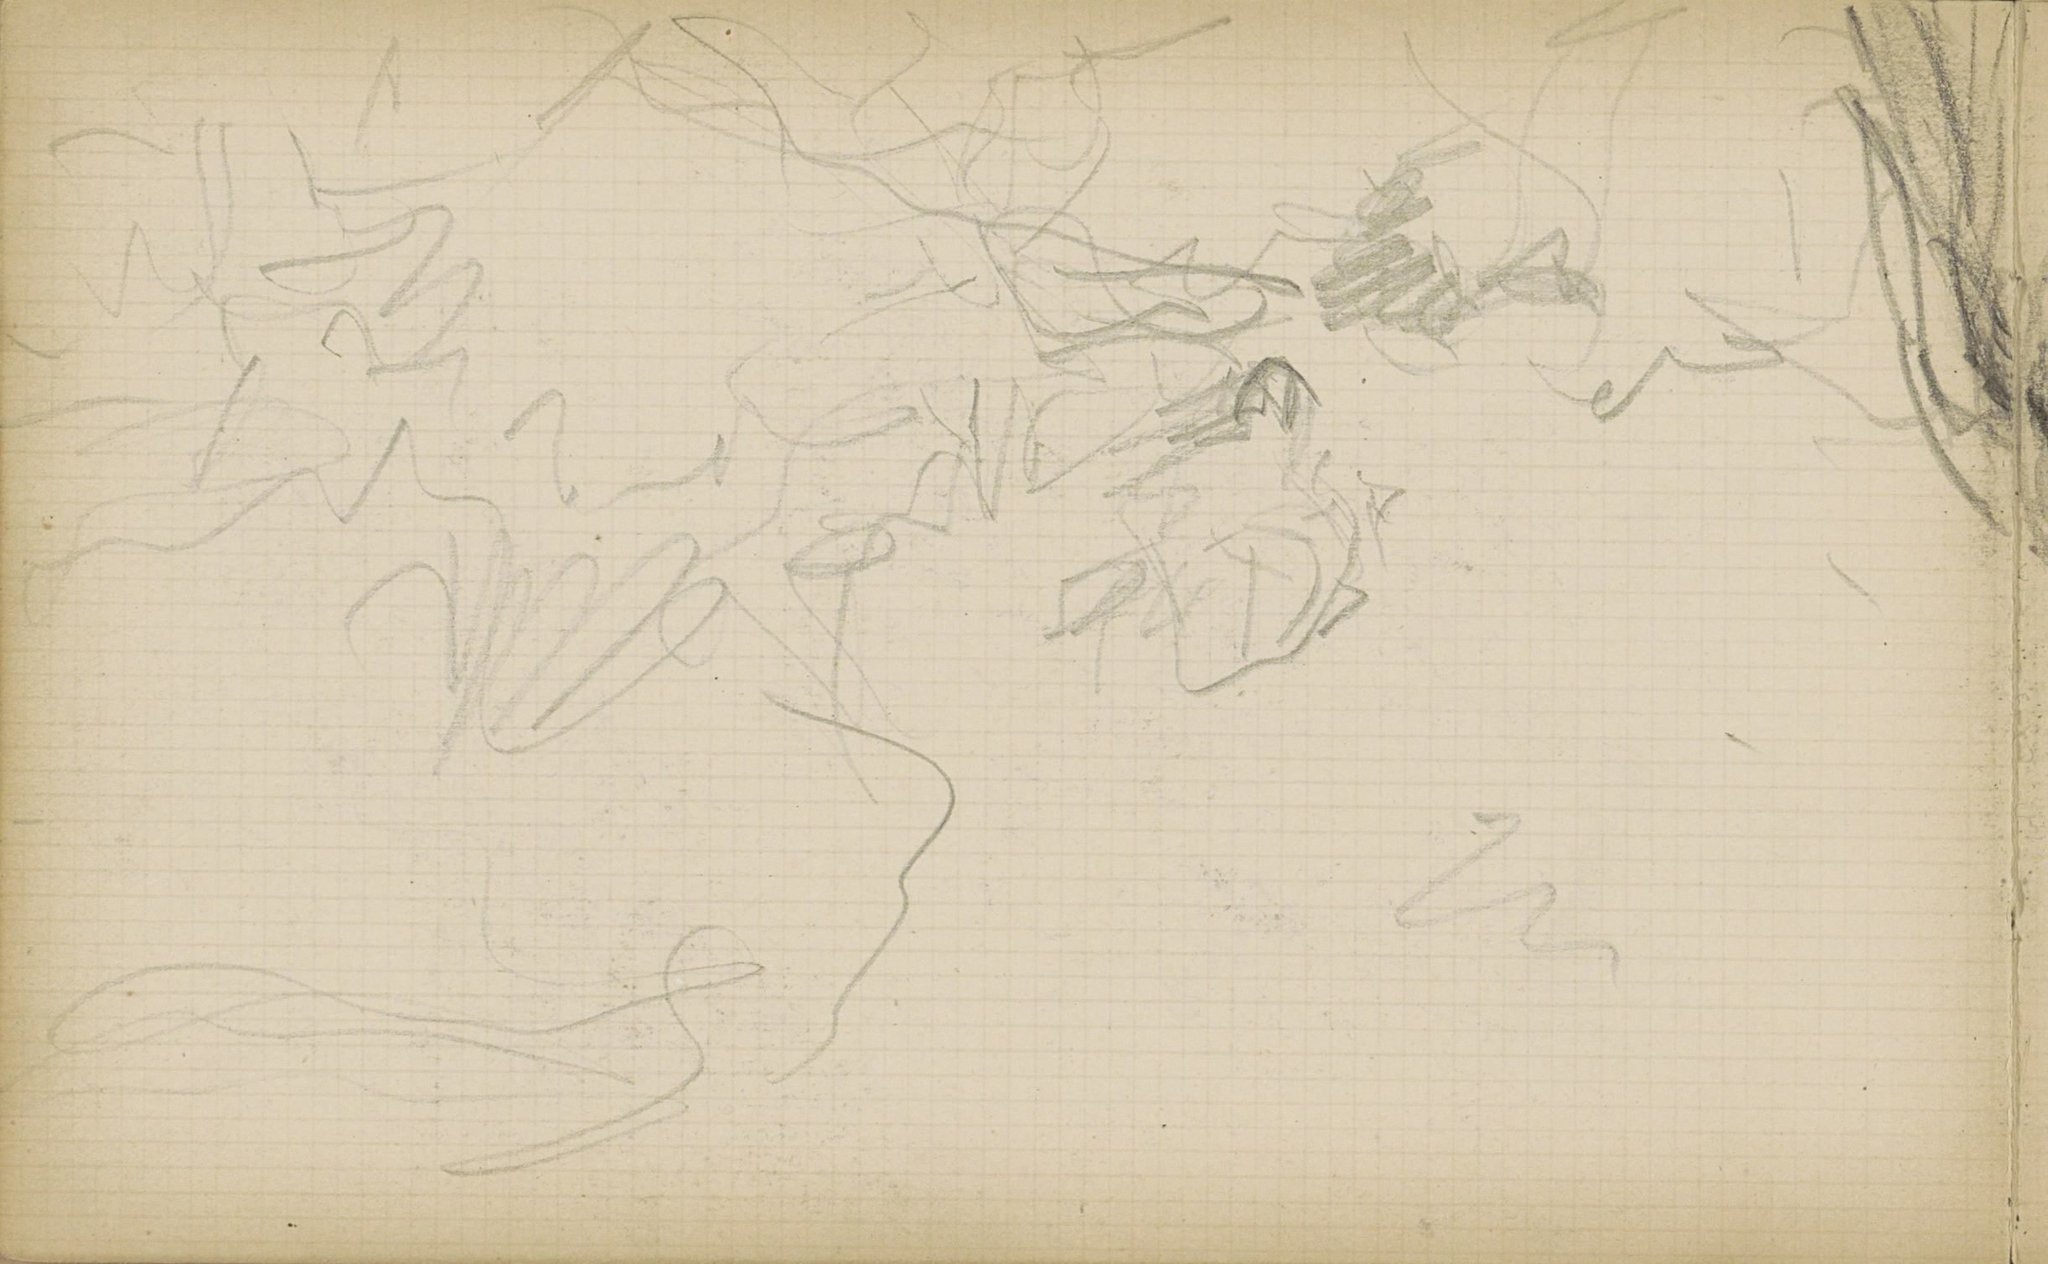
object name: sketchbook leaf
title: Studie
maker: matthijs maris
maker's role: draughtsman, painter, print maker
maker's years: 1839-1917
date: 1849-1917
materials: pencil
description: Blad 17 verso uit een schetsboek met 35 bladen.